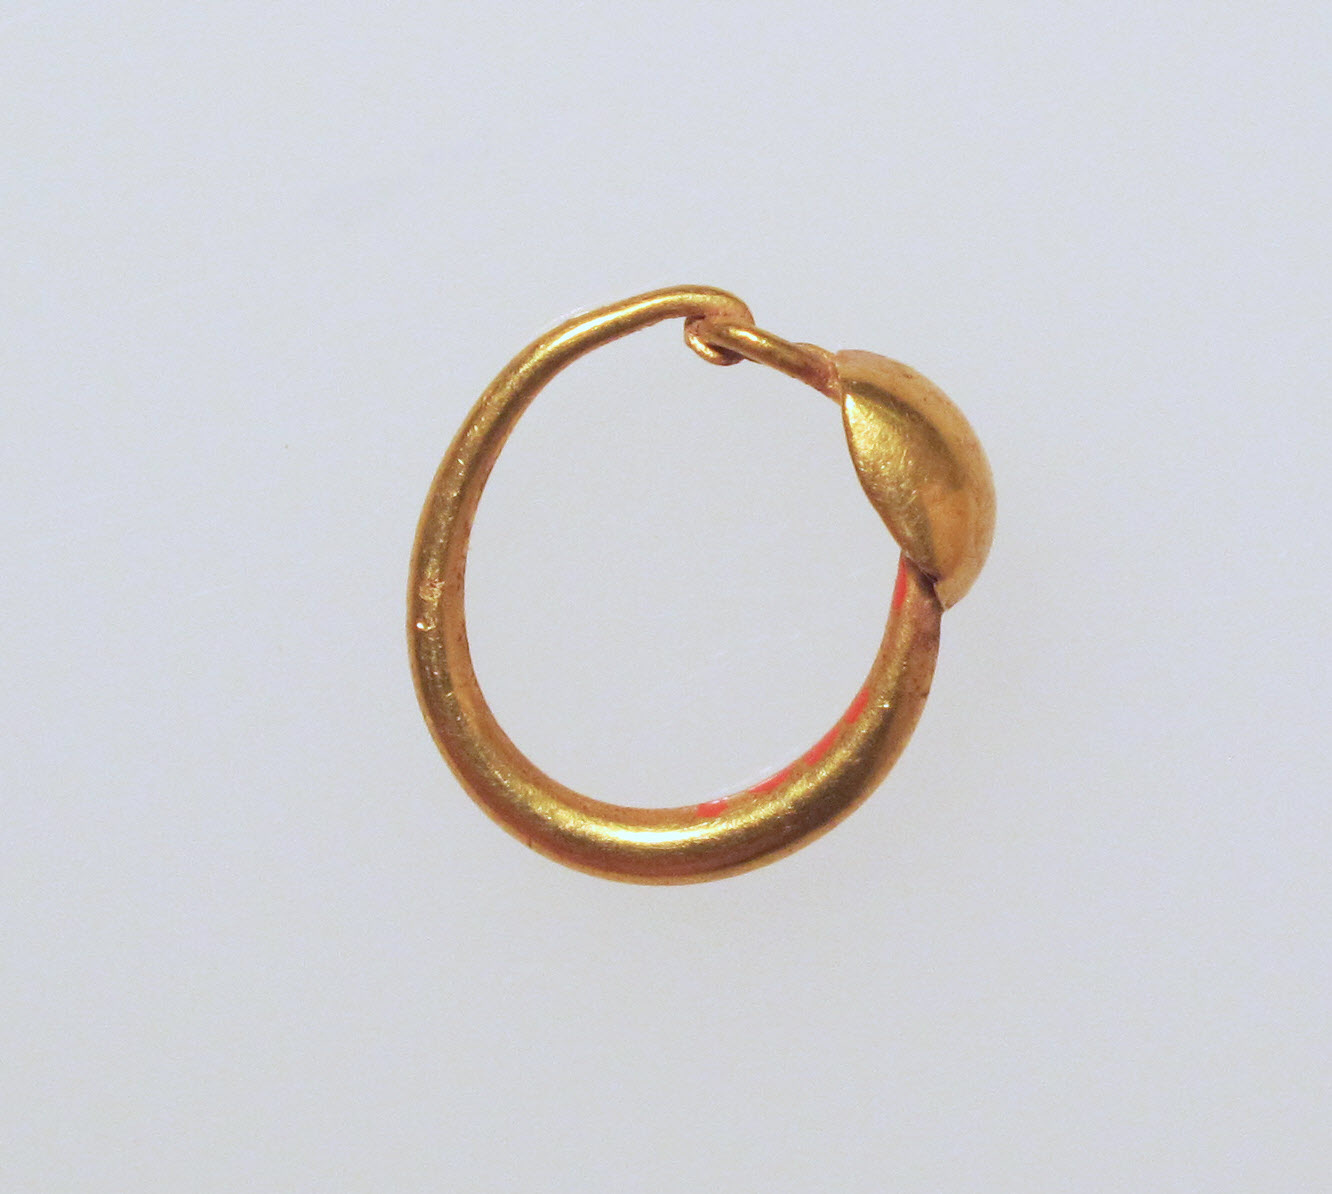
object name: earring with plain loop and disc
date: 7000 BCE-330 CE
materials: gold